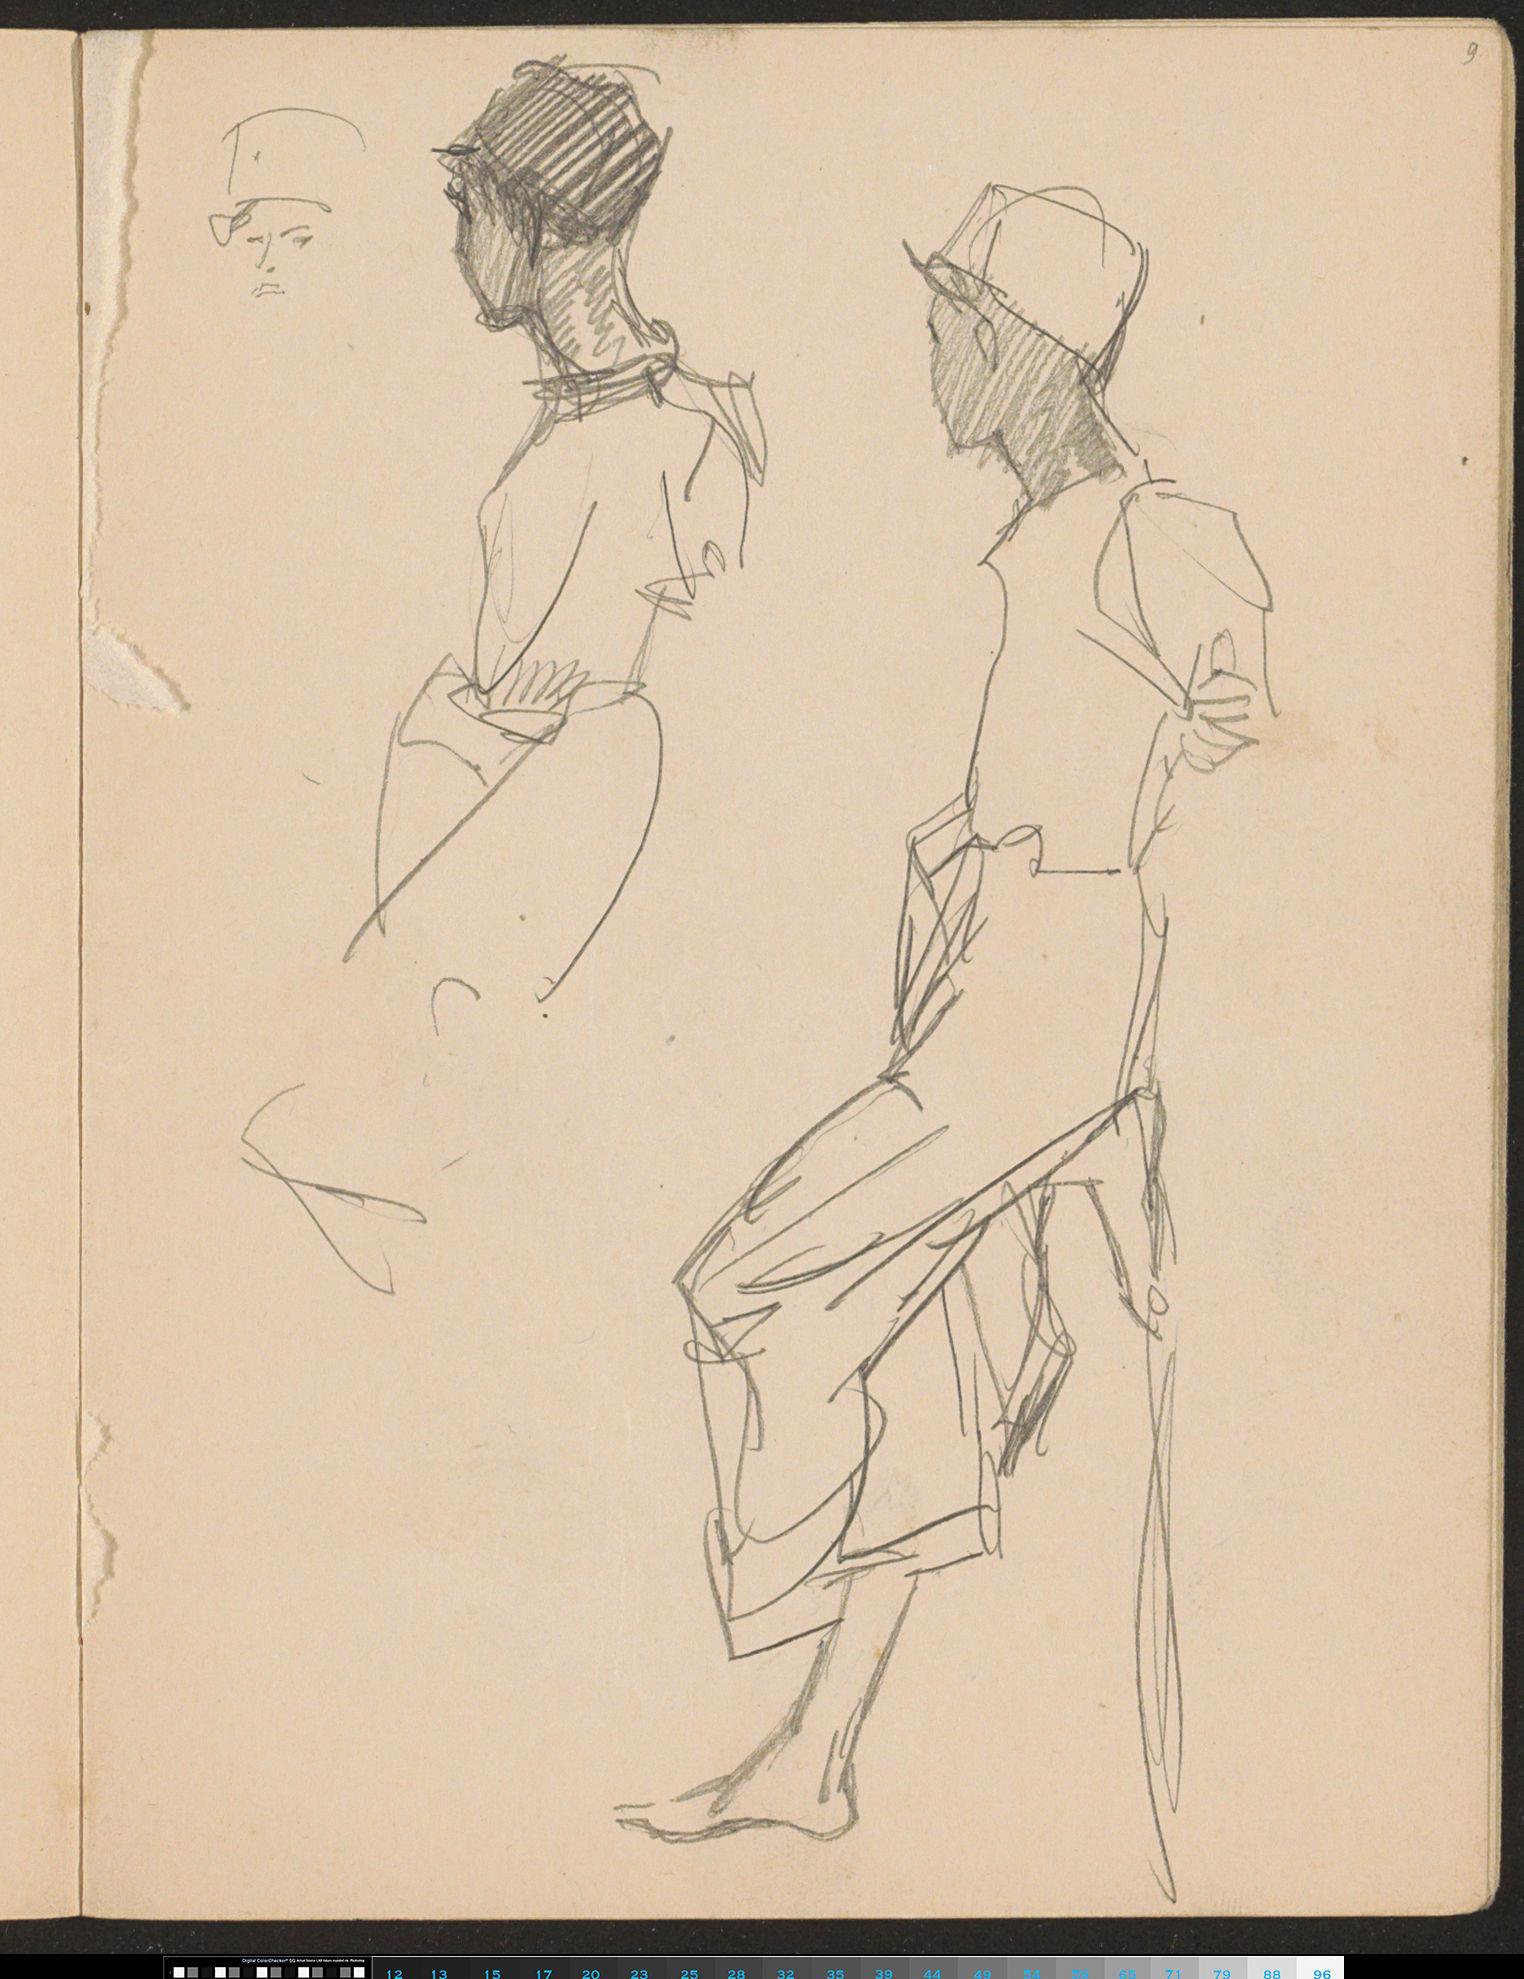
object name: sketchbook leaf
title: Studies van een leunende man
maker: isaac israels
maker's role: draughtsman, painter, print maker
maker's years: 1865-1934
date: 1921-1922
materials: paper, pencil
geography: dutch east indies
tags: asiatic races and peoples, huddled figure, adult man (+ leaning), dutch east indies, the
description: Indische figuurstudies. Pagina 9 uit schetsboek XXXIV met 24 pagina's.